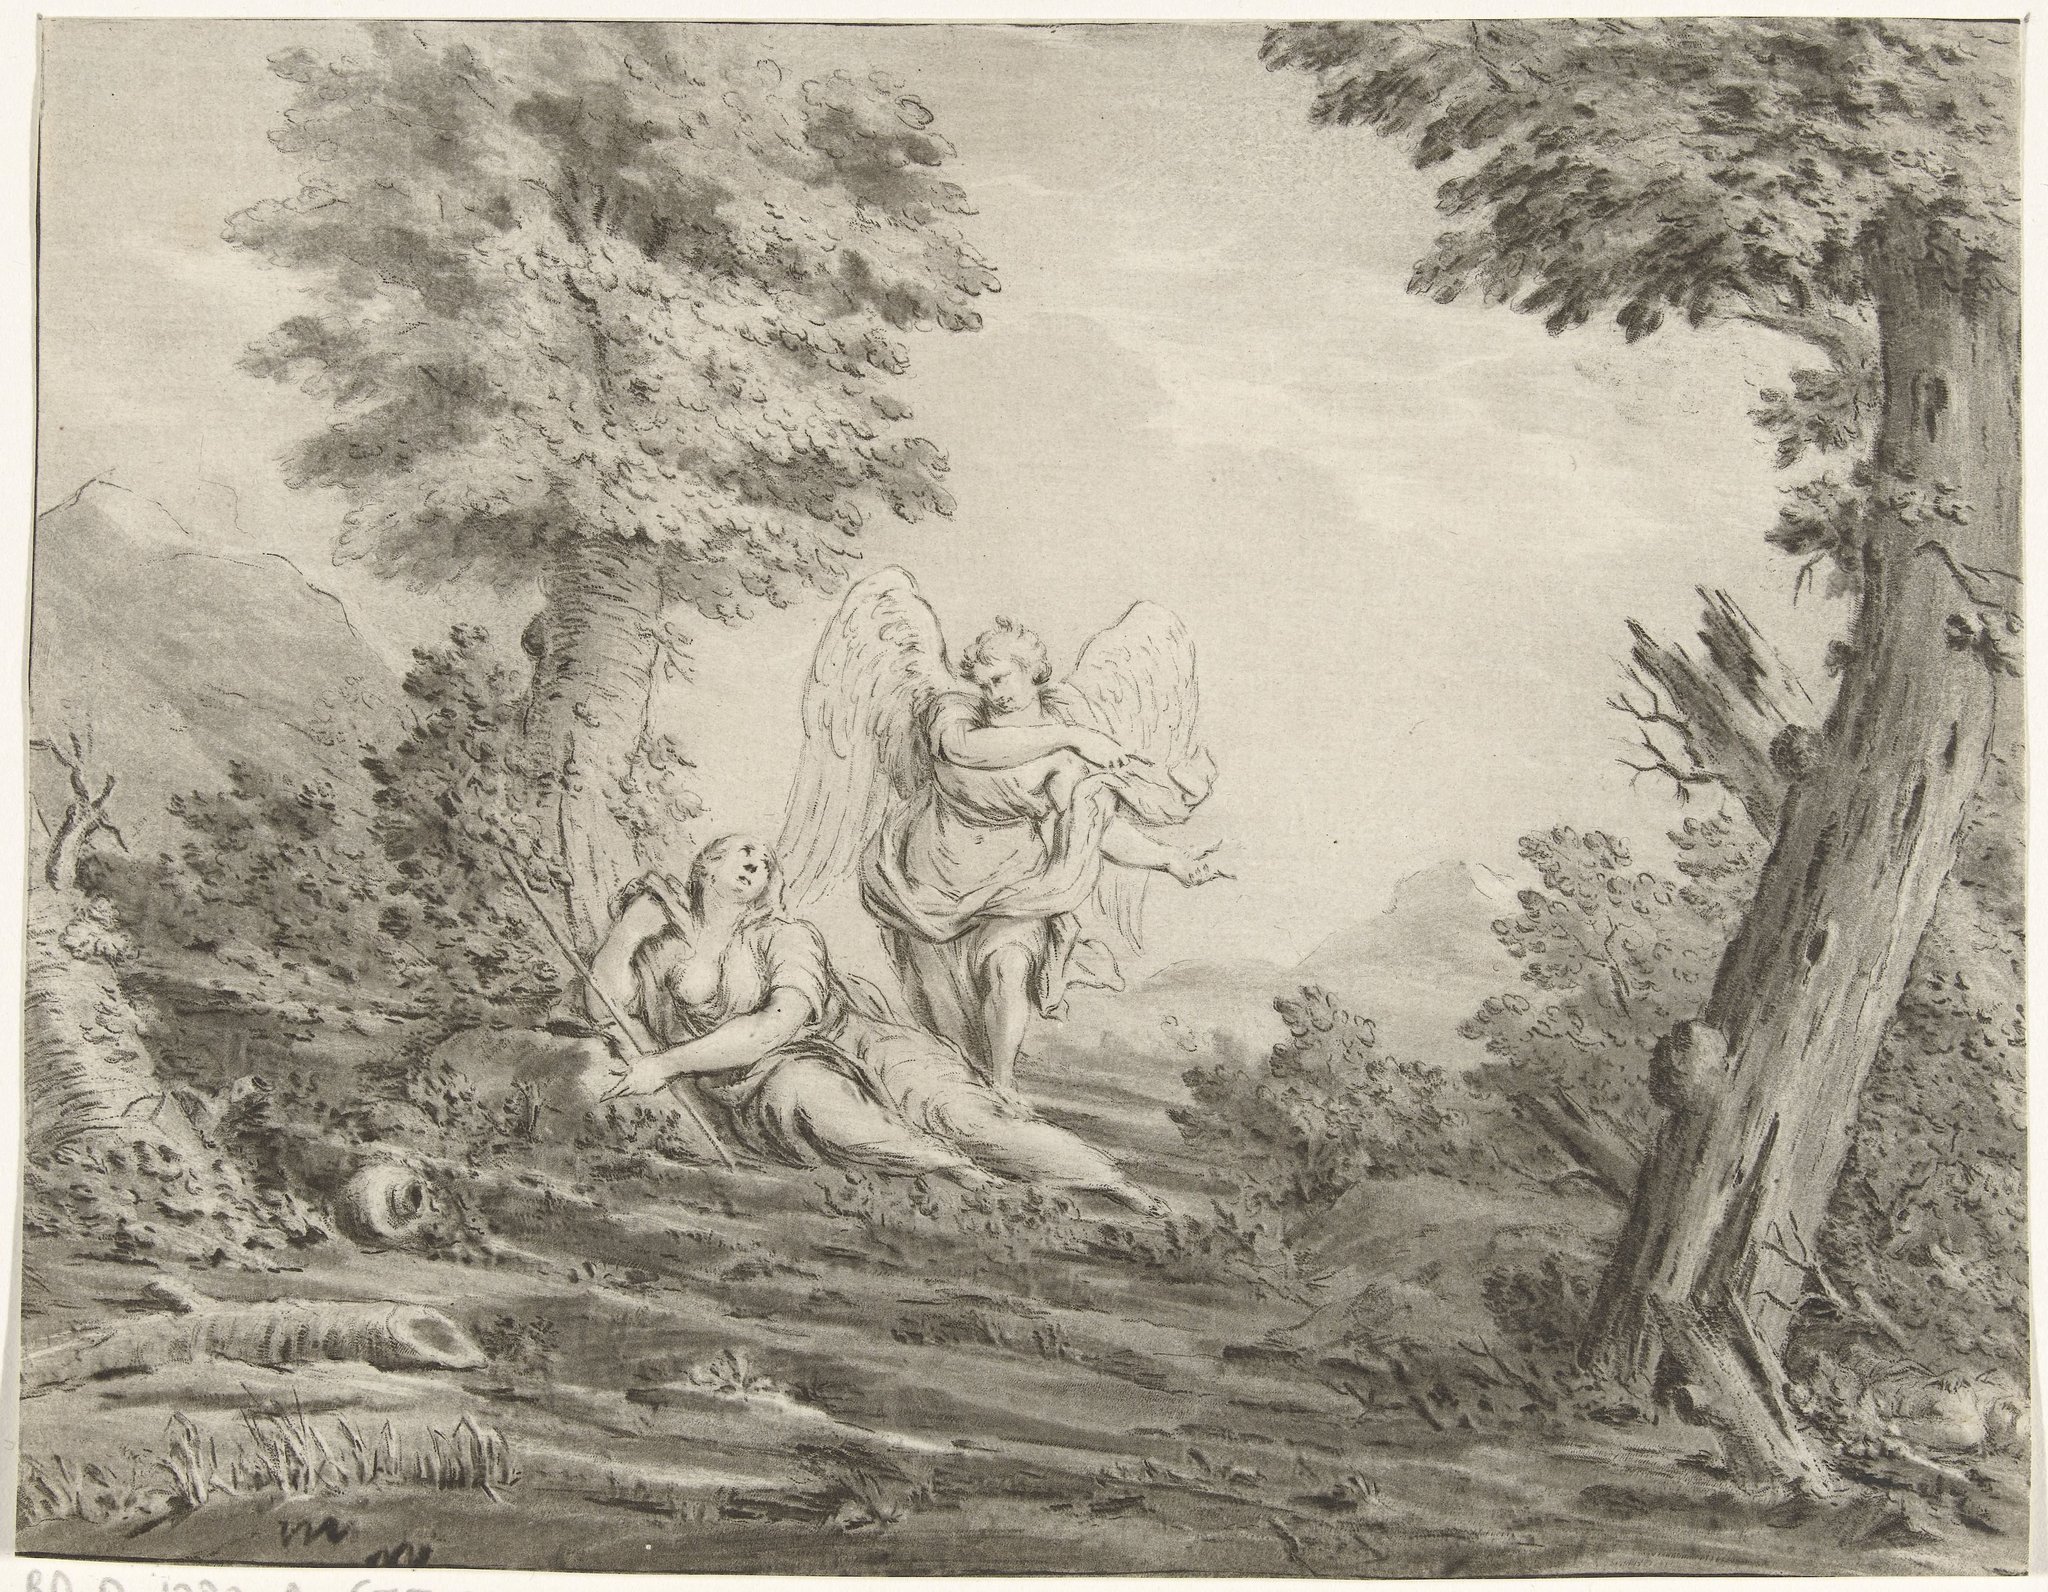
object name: print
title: Hagar in de woestijn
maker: jurriaan cootwijck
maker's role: print maker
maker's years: 1714-1798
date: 1759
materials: paper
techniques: print drawing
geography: paris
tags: an angel appears and reveals a well of water to hagar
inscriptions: collector's mark: Lugt 2228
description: Hagar ligt op de grond in een bergachtig landschap. Een engel wijst haar naar een waterbron. Rechts ligt Ismaël, het kind van Hagar, verscholen onder een struik.